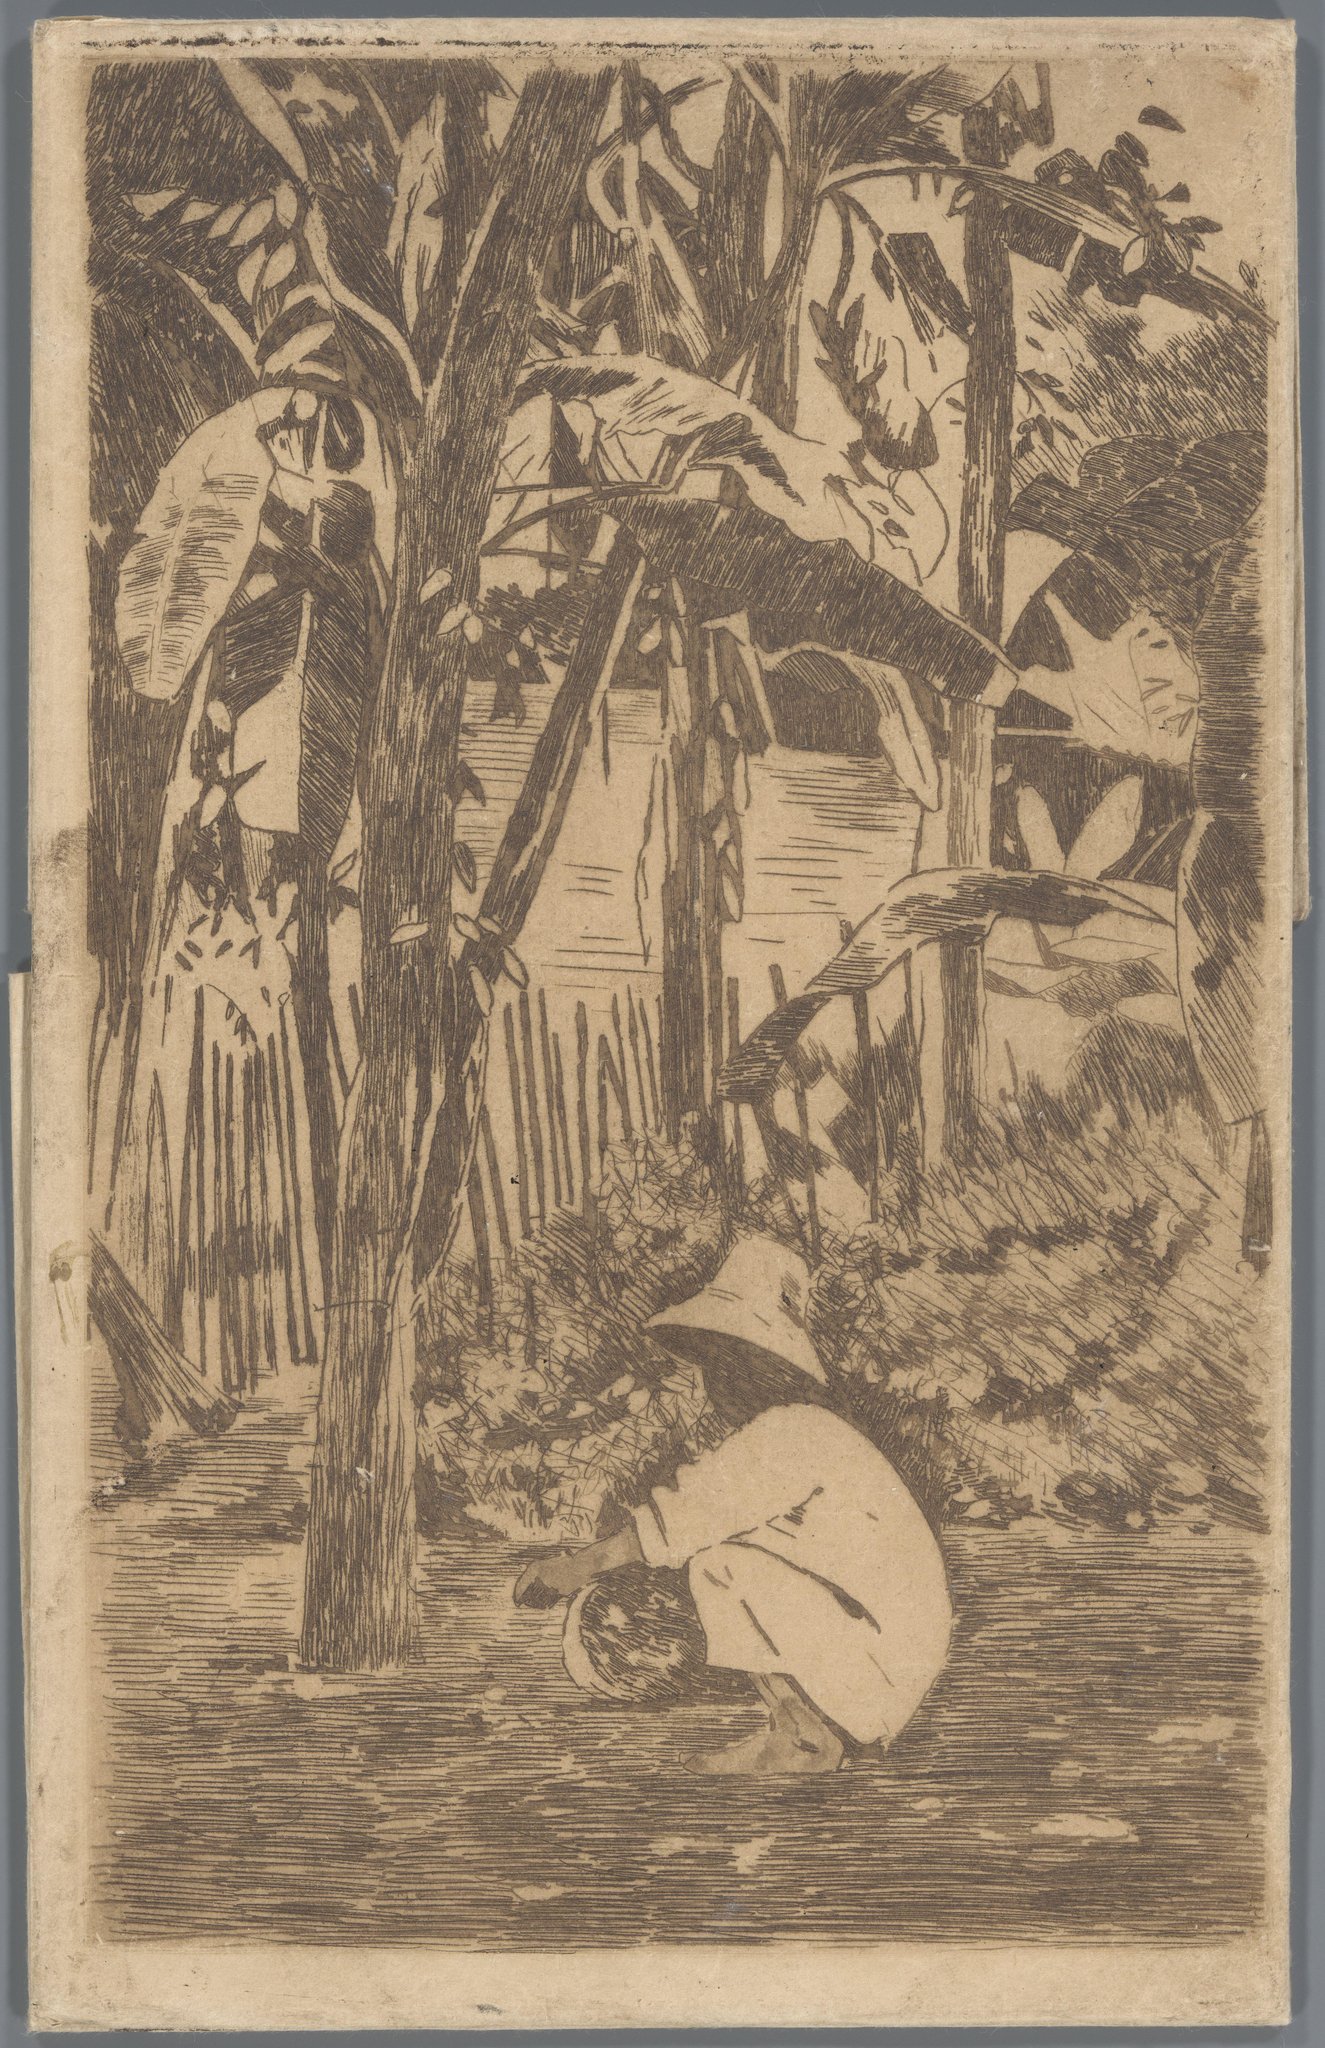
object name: print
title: Hurkende jongen in een tuin, Buitenzorg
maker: willem witsen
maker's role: draughtsman, painter, print maker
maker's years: 1860-1923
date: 1921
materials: paper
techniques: etching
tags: garden, head-gear: hat, sitting on the ground